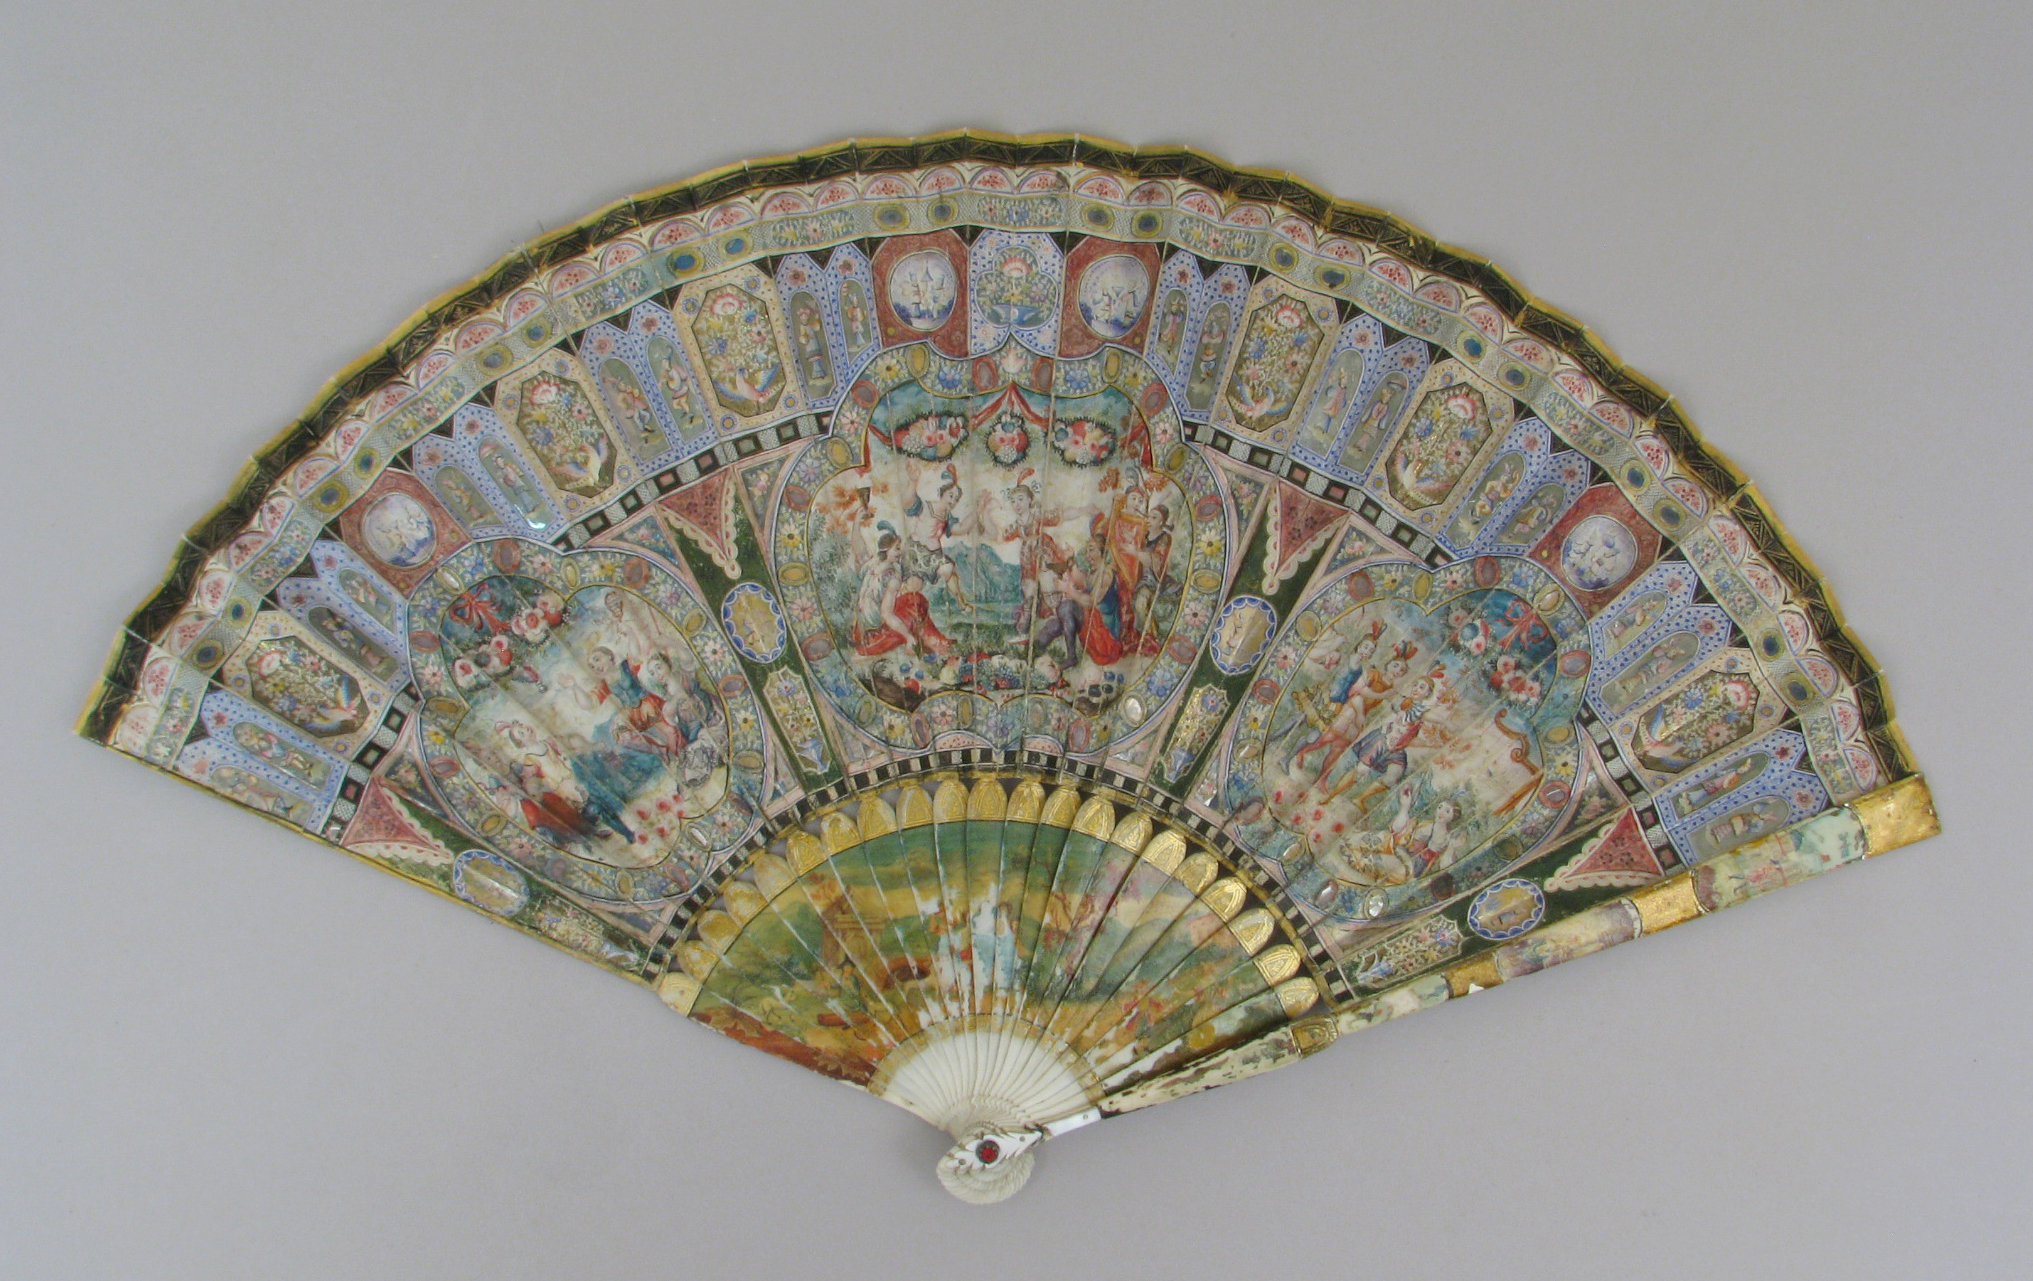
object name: fan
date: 1700-1723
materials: ivory, mica, silk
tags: birds,men,women,dancing